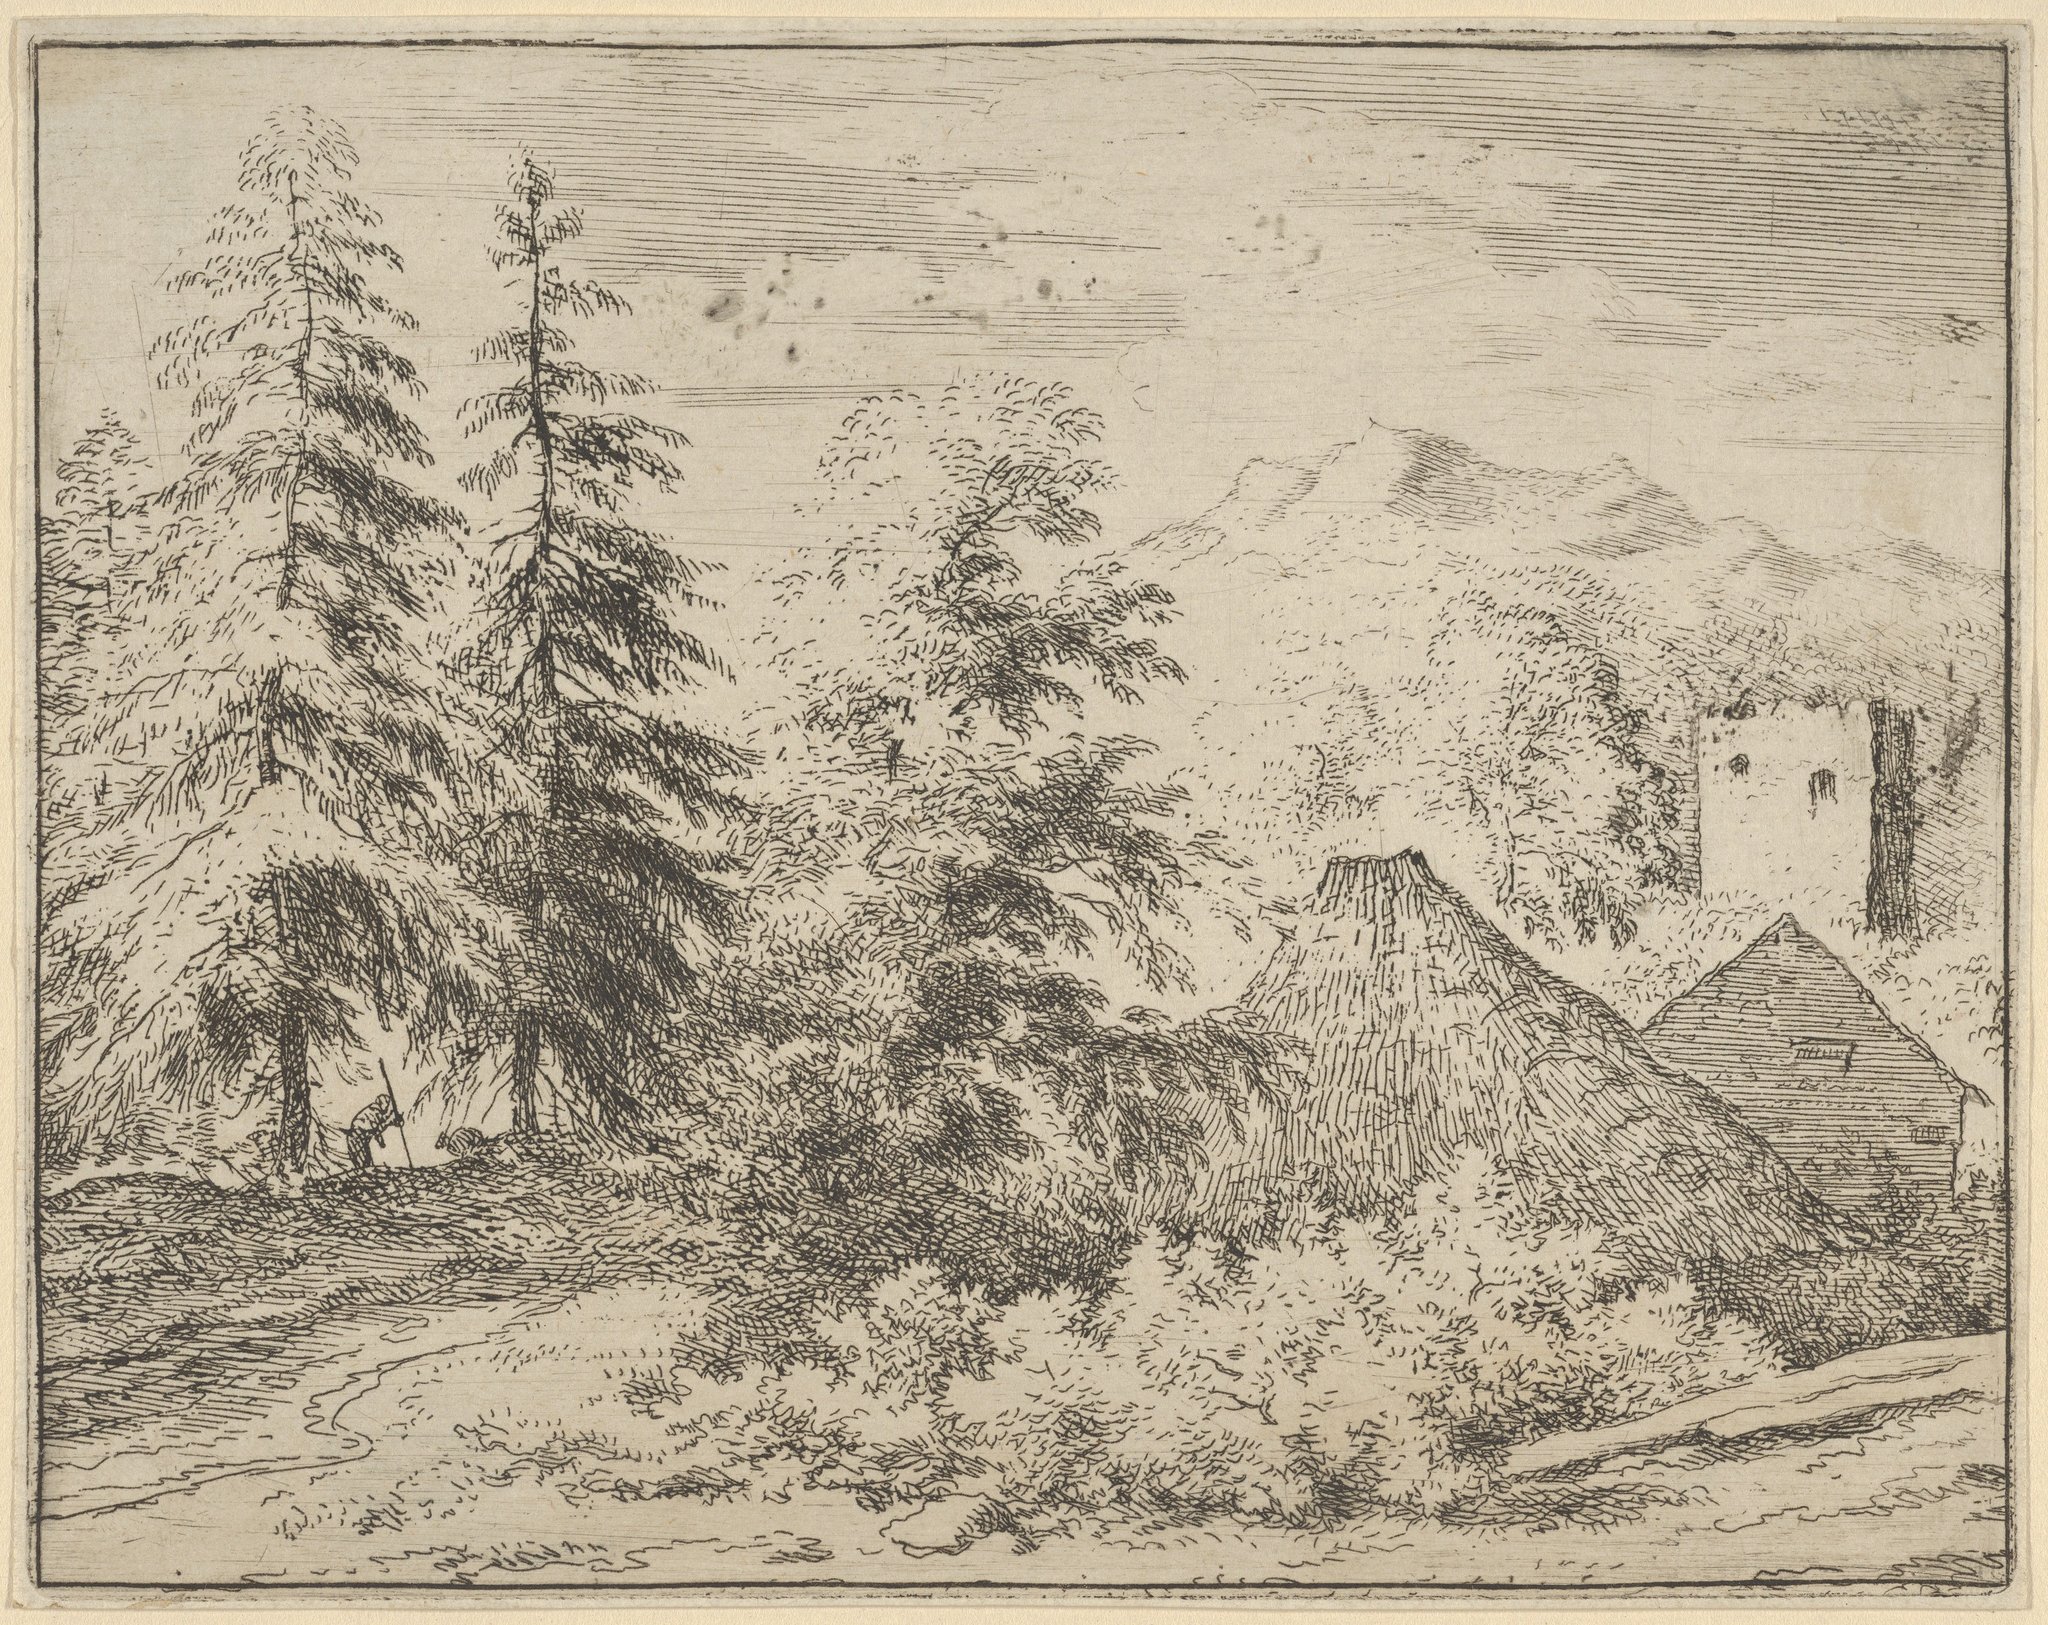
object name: print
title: The Man Between the Two Fir Trees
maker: allart van everdingen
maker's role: artist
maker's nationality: dutch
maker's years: 1621-1675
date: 1621-1675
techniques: engraving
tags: houses,men,mountains,trees